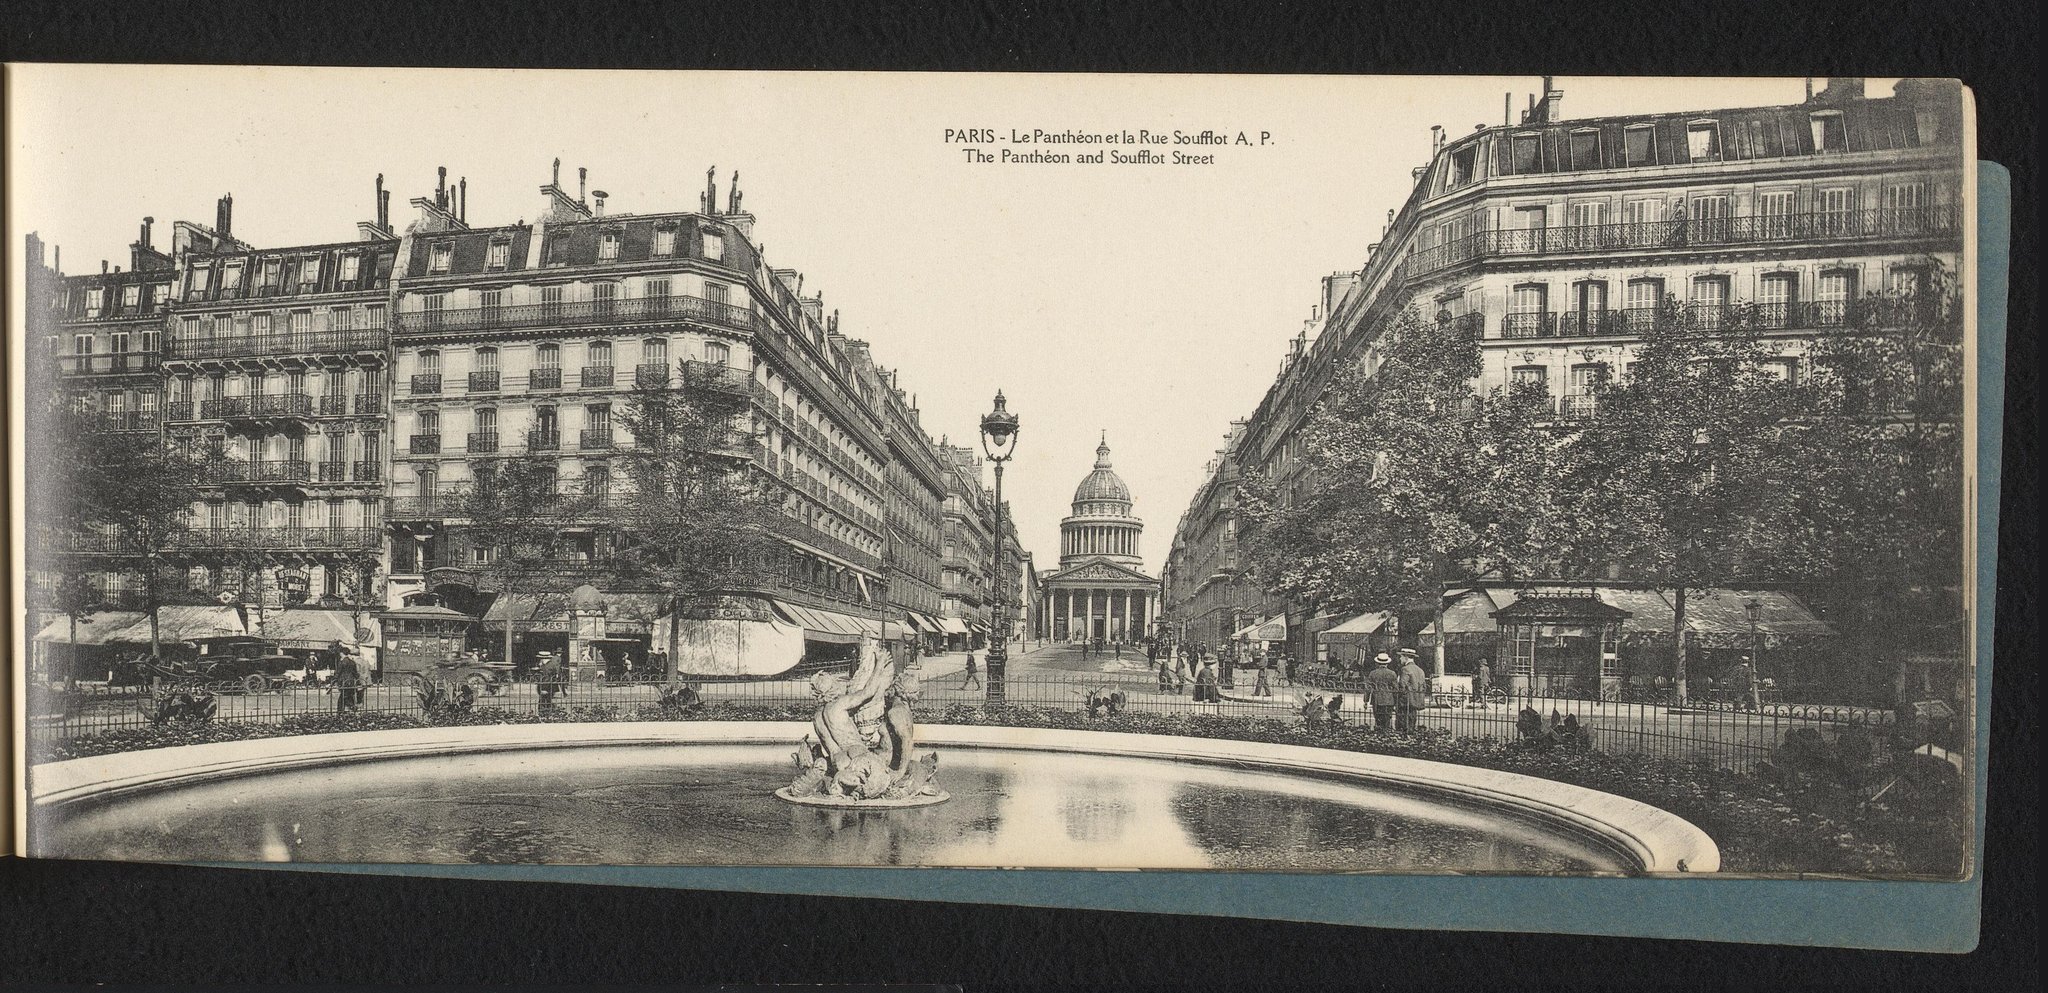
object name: photomechanical print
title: Paris. Le Panthéon et la Rue Soufflot / The Panthéon and Soufflot Street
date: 1910-1925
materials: cardboard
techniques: photograph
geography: paris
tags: church (exterior), sculpture, square, place, circus, etc. (+ city(-scape) with figures, staffage)